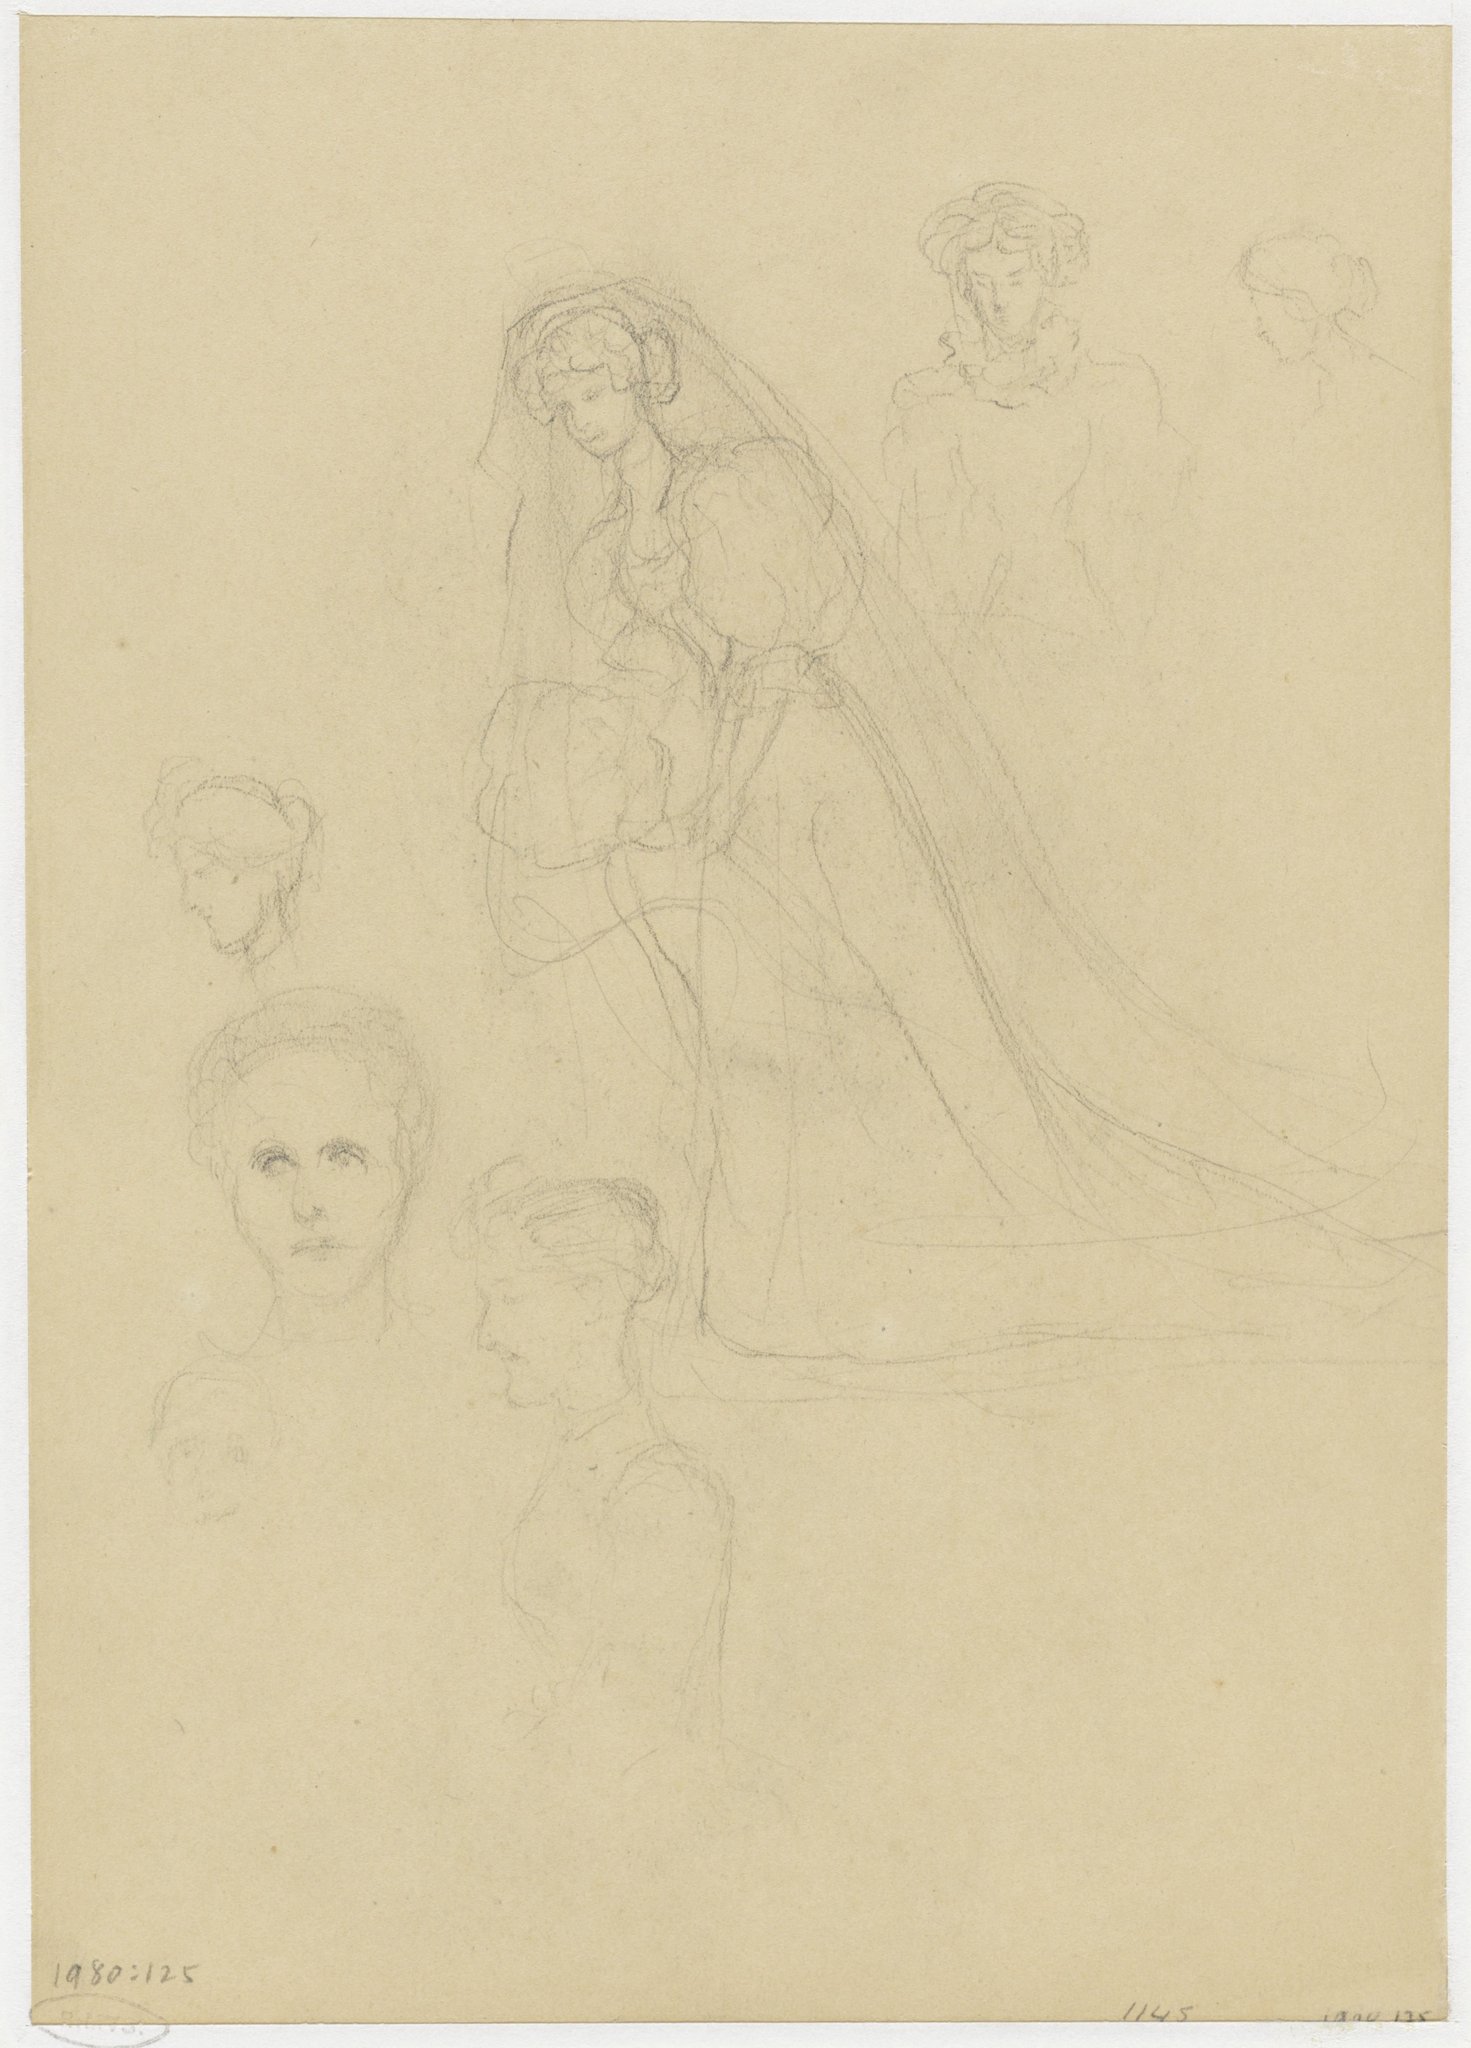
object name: drawing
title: Studies van een bruid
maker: jozef israëls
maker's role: draughtsman, painter, print maker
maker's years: 1824-1911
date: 1834-1911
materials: chalk, paper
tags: bride (in wedding-dress)